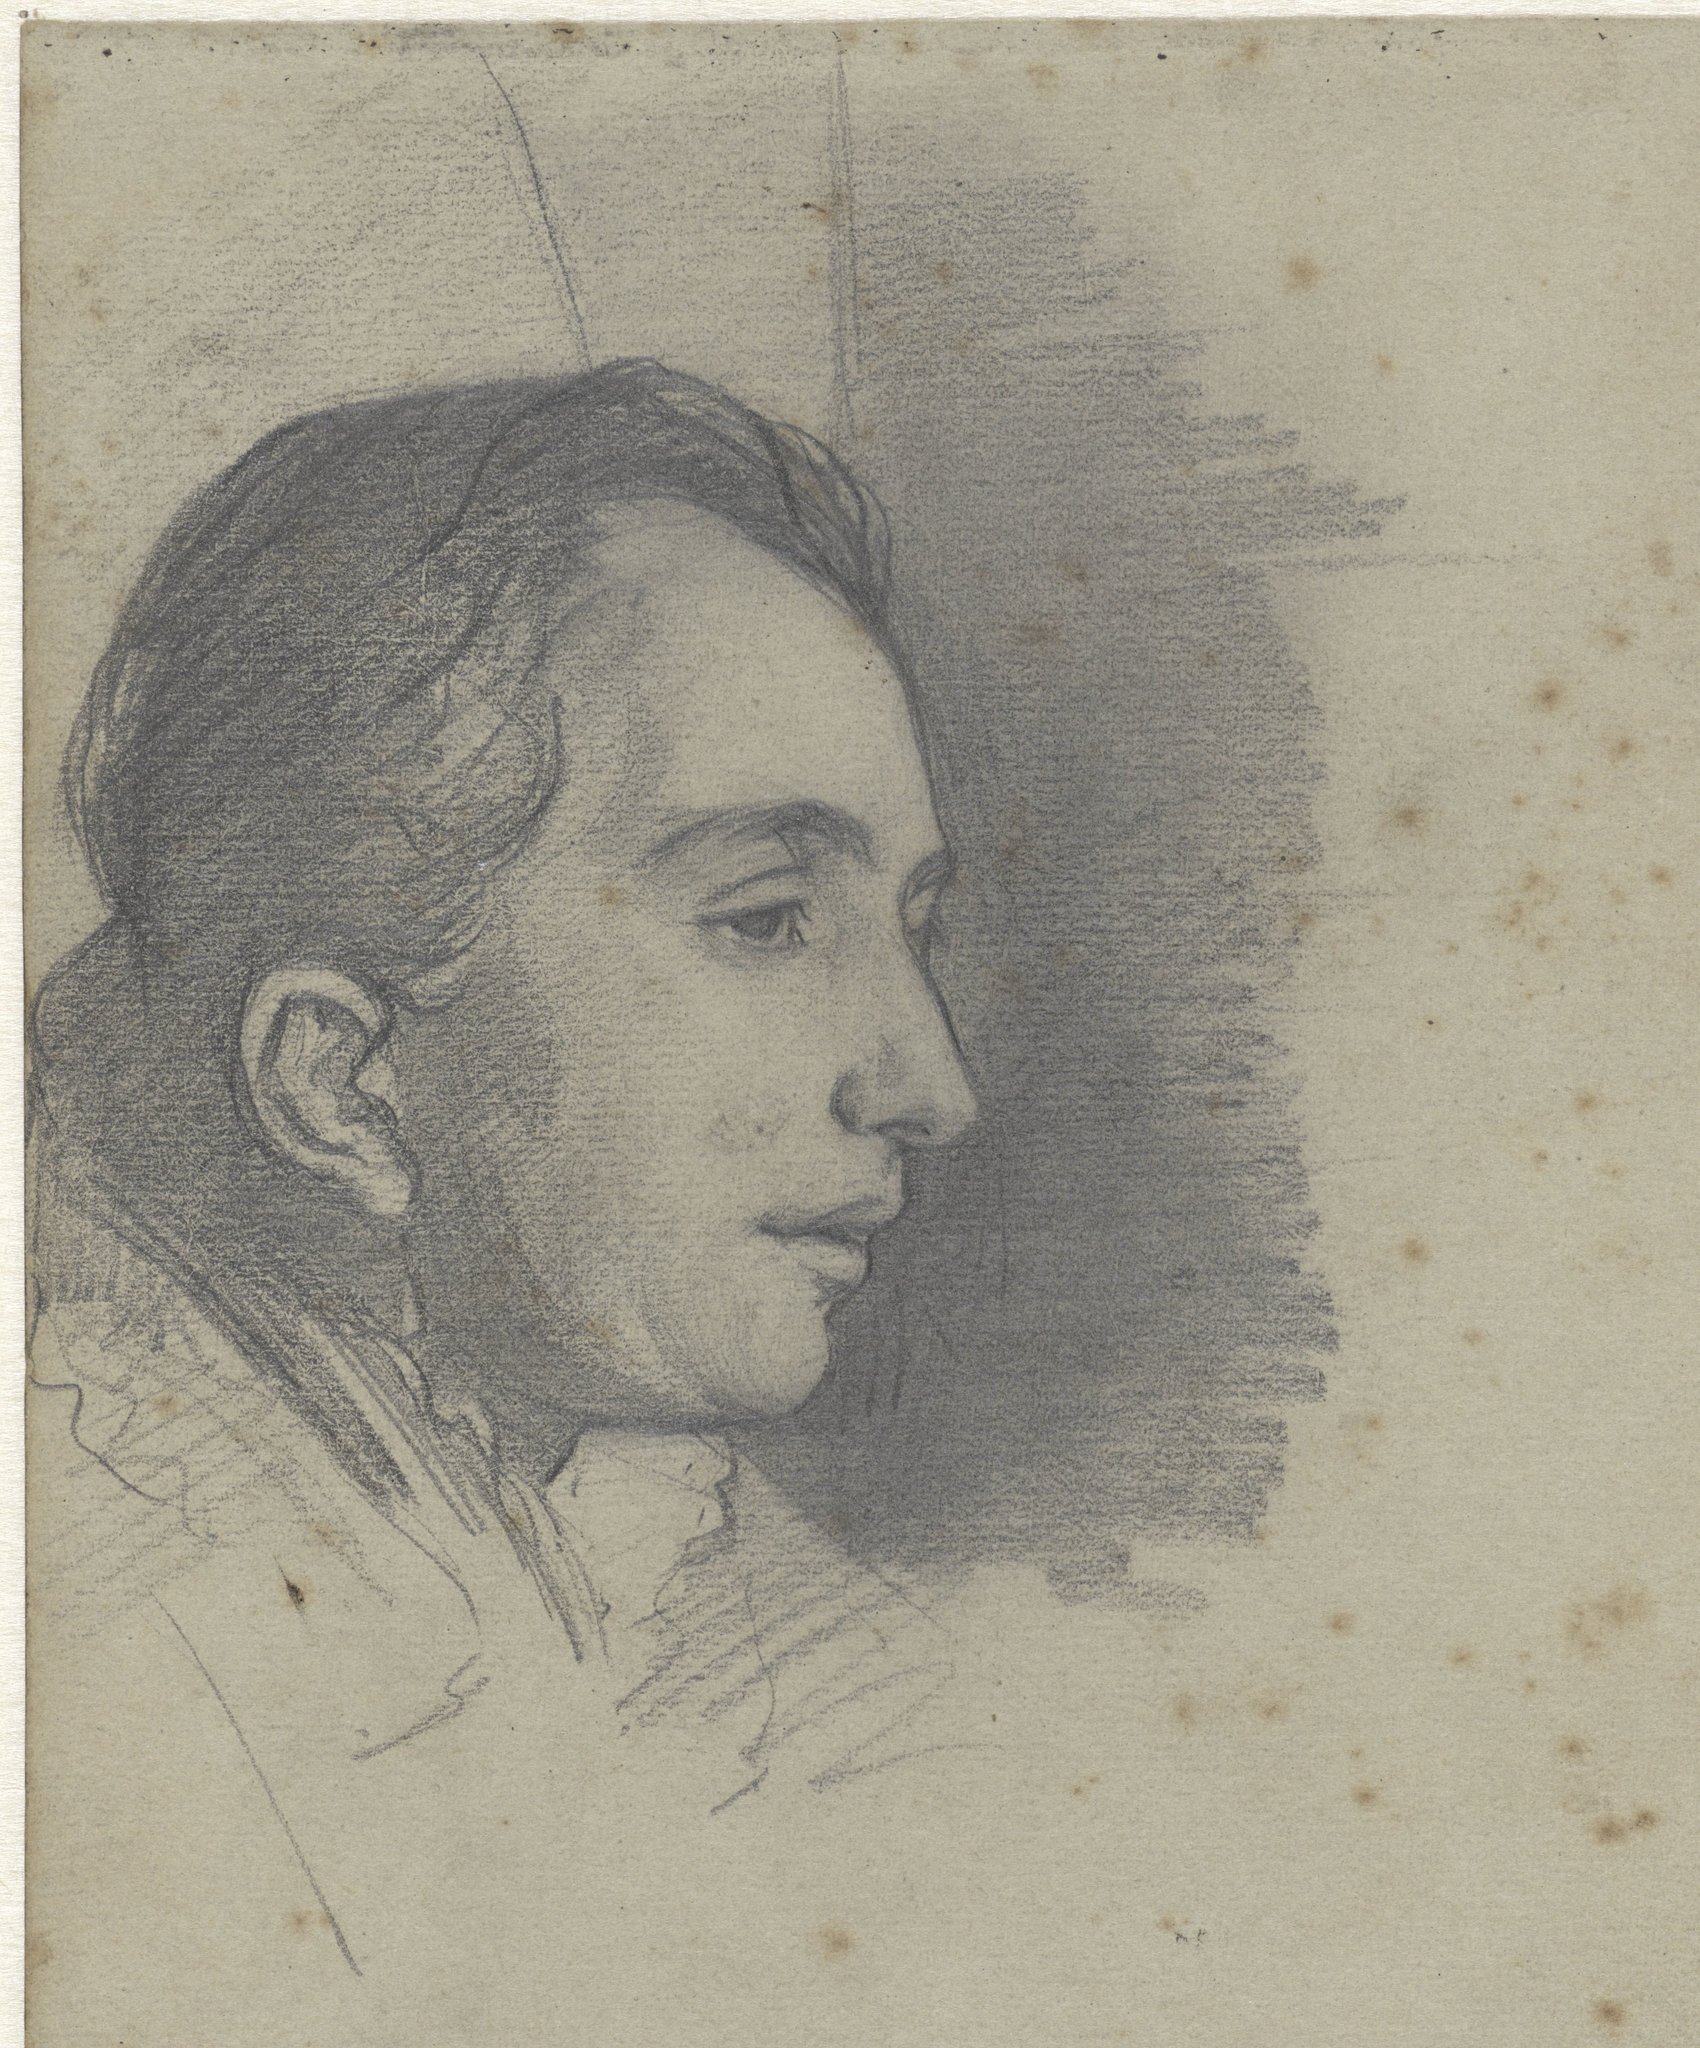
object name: drawing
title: Portret van een man, naar rechts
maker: jac van looij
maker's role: draughtsman, painter, print maker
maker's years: 1855-1930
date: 1865-1930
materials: paper, pencil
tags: anonymous historical person portrayed alone